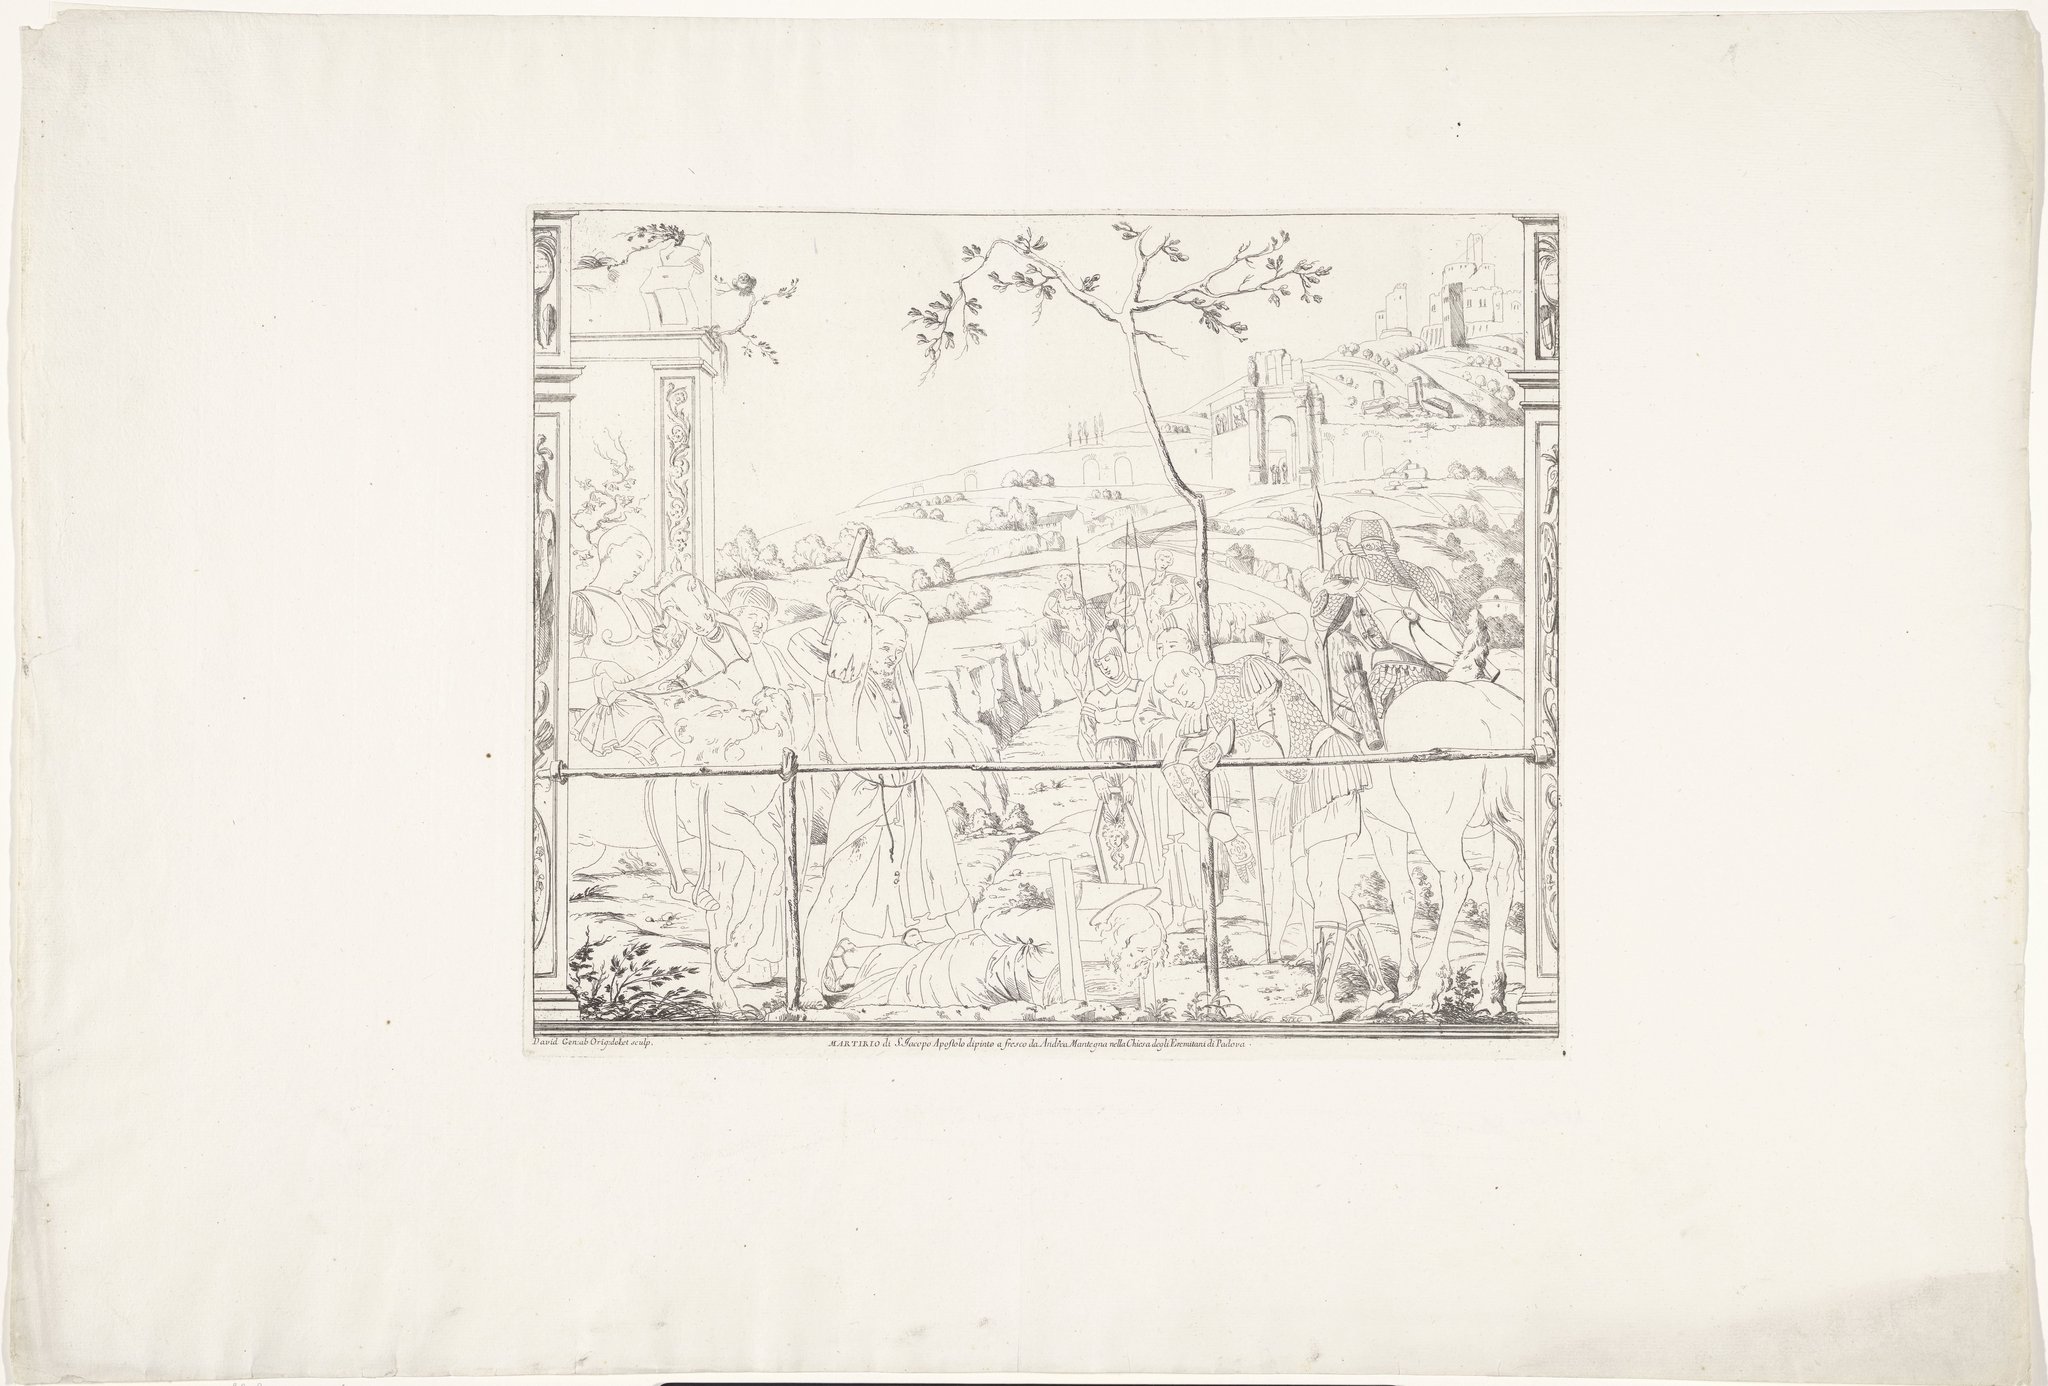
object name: print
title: De fresco's van Andrea Mantegna in de Chiesa degli Eremitani in Padua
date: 1776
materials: paper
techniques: etching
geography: italy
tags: beheading of james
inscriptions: collector's mark: Lugt 2228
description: Prent uit een reeks van vier prenten (+ titelprent) met weergaven van de fresco's van Andrea Mategna in de Chiesa degli Eremitani in Padua (fresco's zijn vernietigd tijdens bombardement 11 maart 1944).